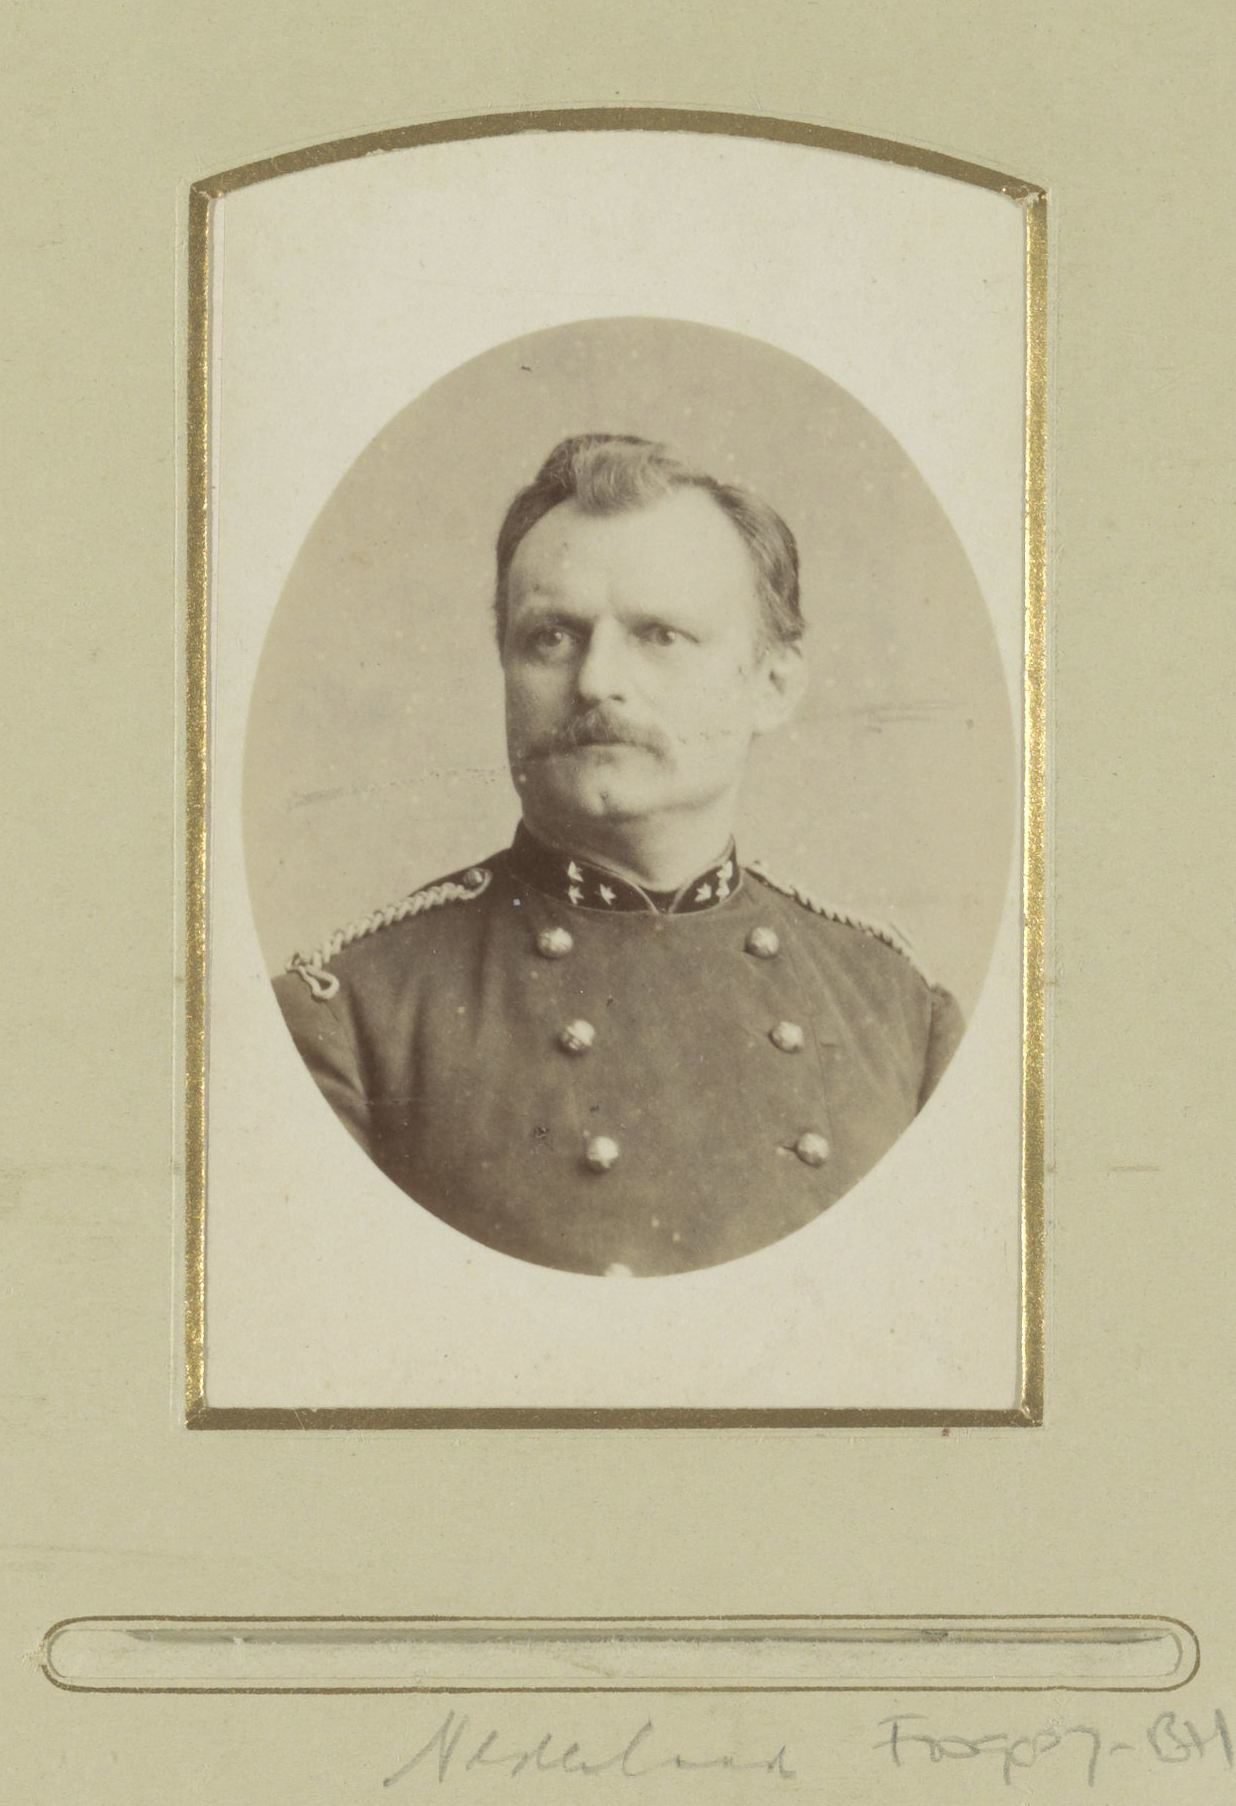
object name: album leaf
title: Portret van een (vermoedelijk) Nederlandse militair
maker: albert greiner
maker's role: fotograaf, fotostudio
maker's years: 1833-1890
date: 1861-1874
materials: cardboard, paper, photographic support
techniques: albumen print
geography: amsterdam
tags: warfare; military affairs, (military) uniforms, division of armed forces, amsterdam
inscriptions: address: ‘Amsterdam Nieuwendijk L. 89.’, inscription: ‘M[...]elche[...]’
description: Onderdeel van Album met cartes-de-visite en kabinetfoto's van militairen in uniform.